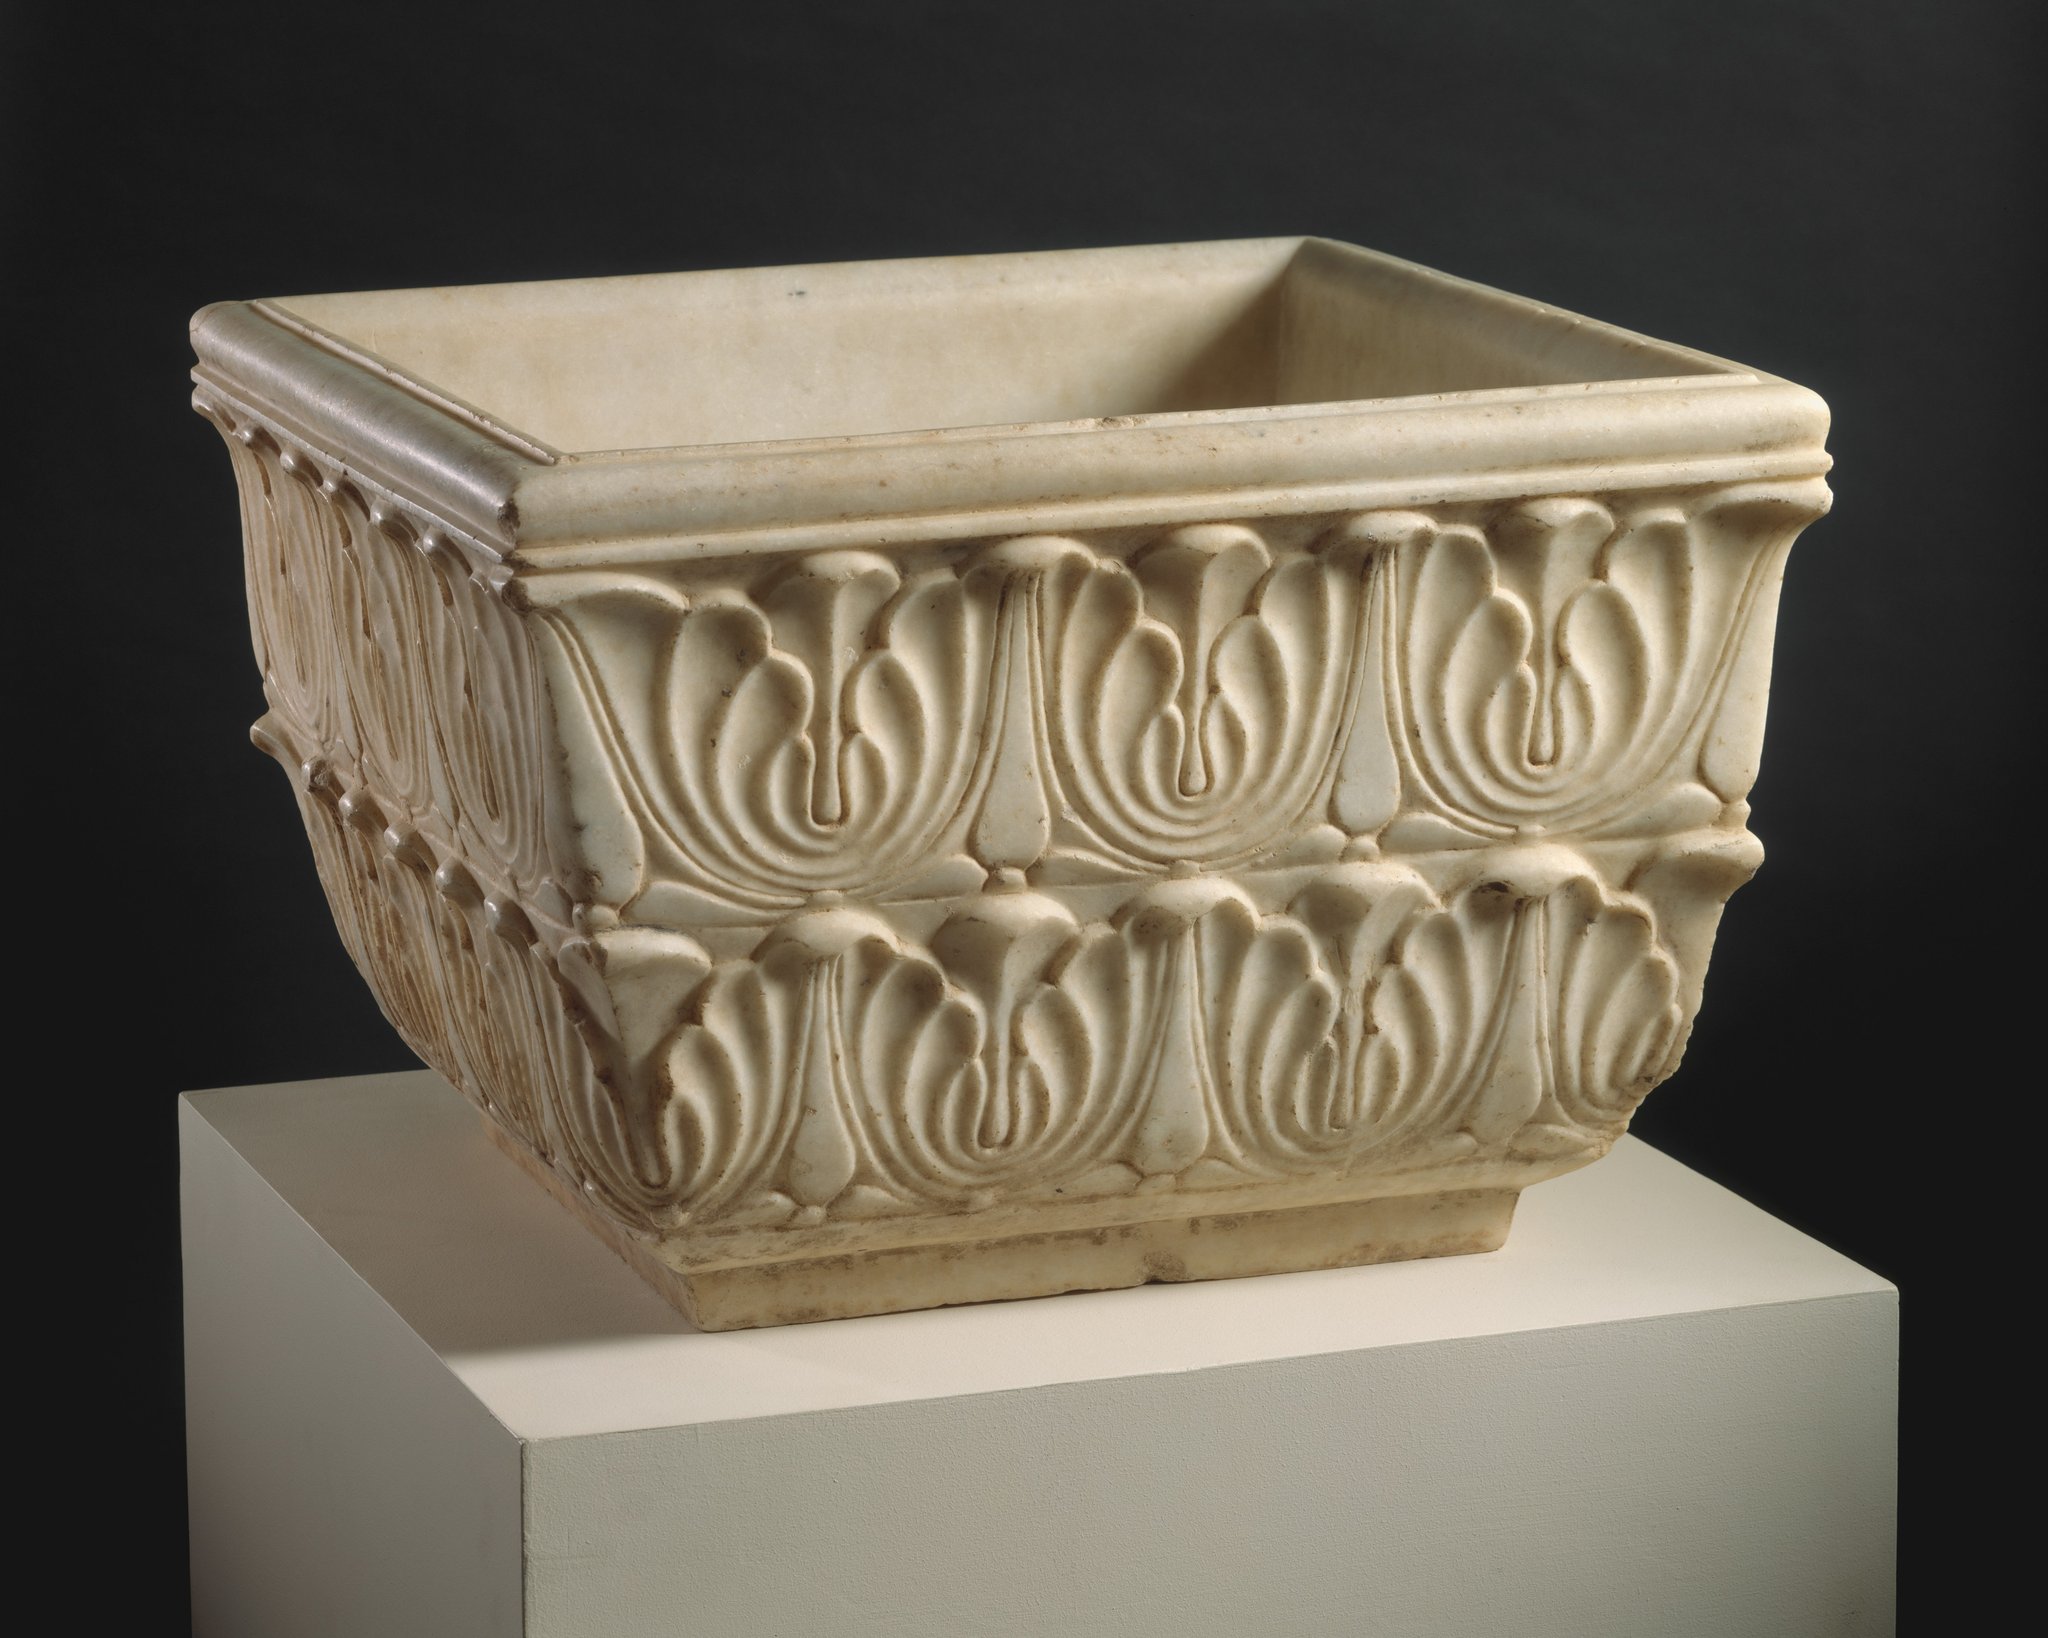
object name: basin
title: Basin with Stylized Lotus Blossoms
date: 1601-1700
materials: marble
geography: india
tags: lotuses